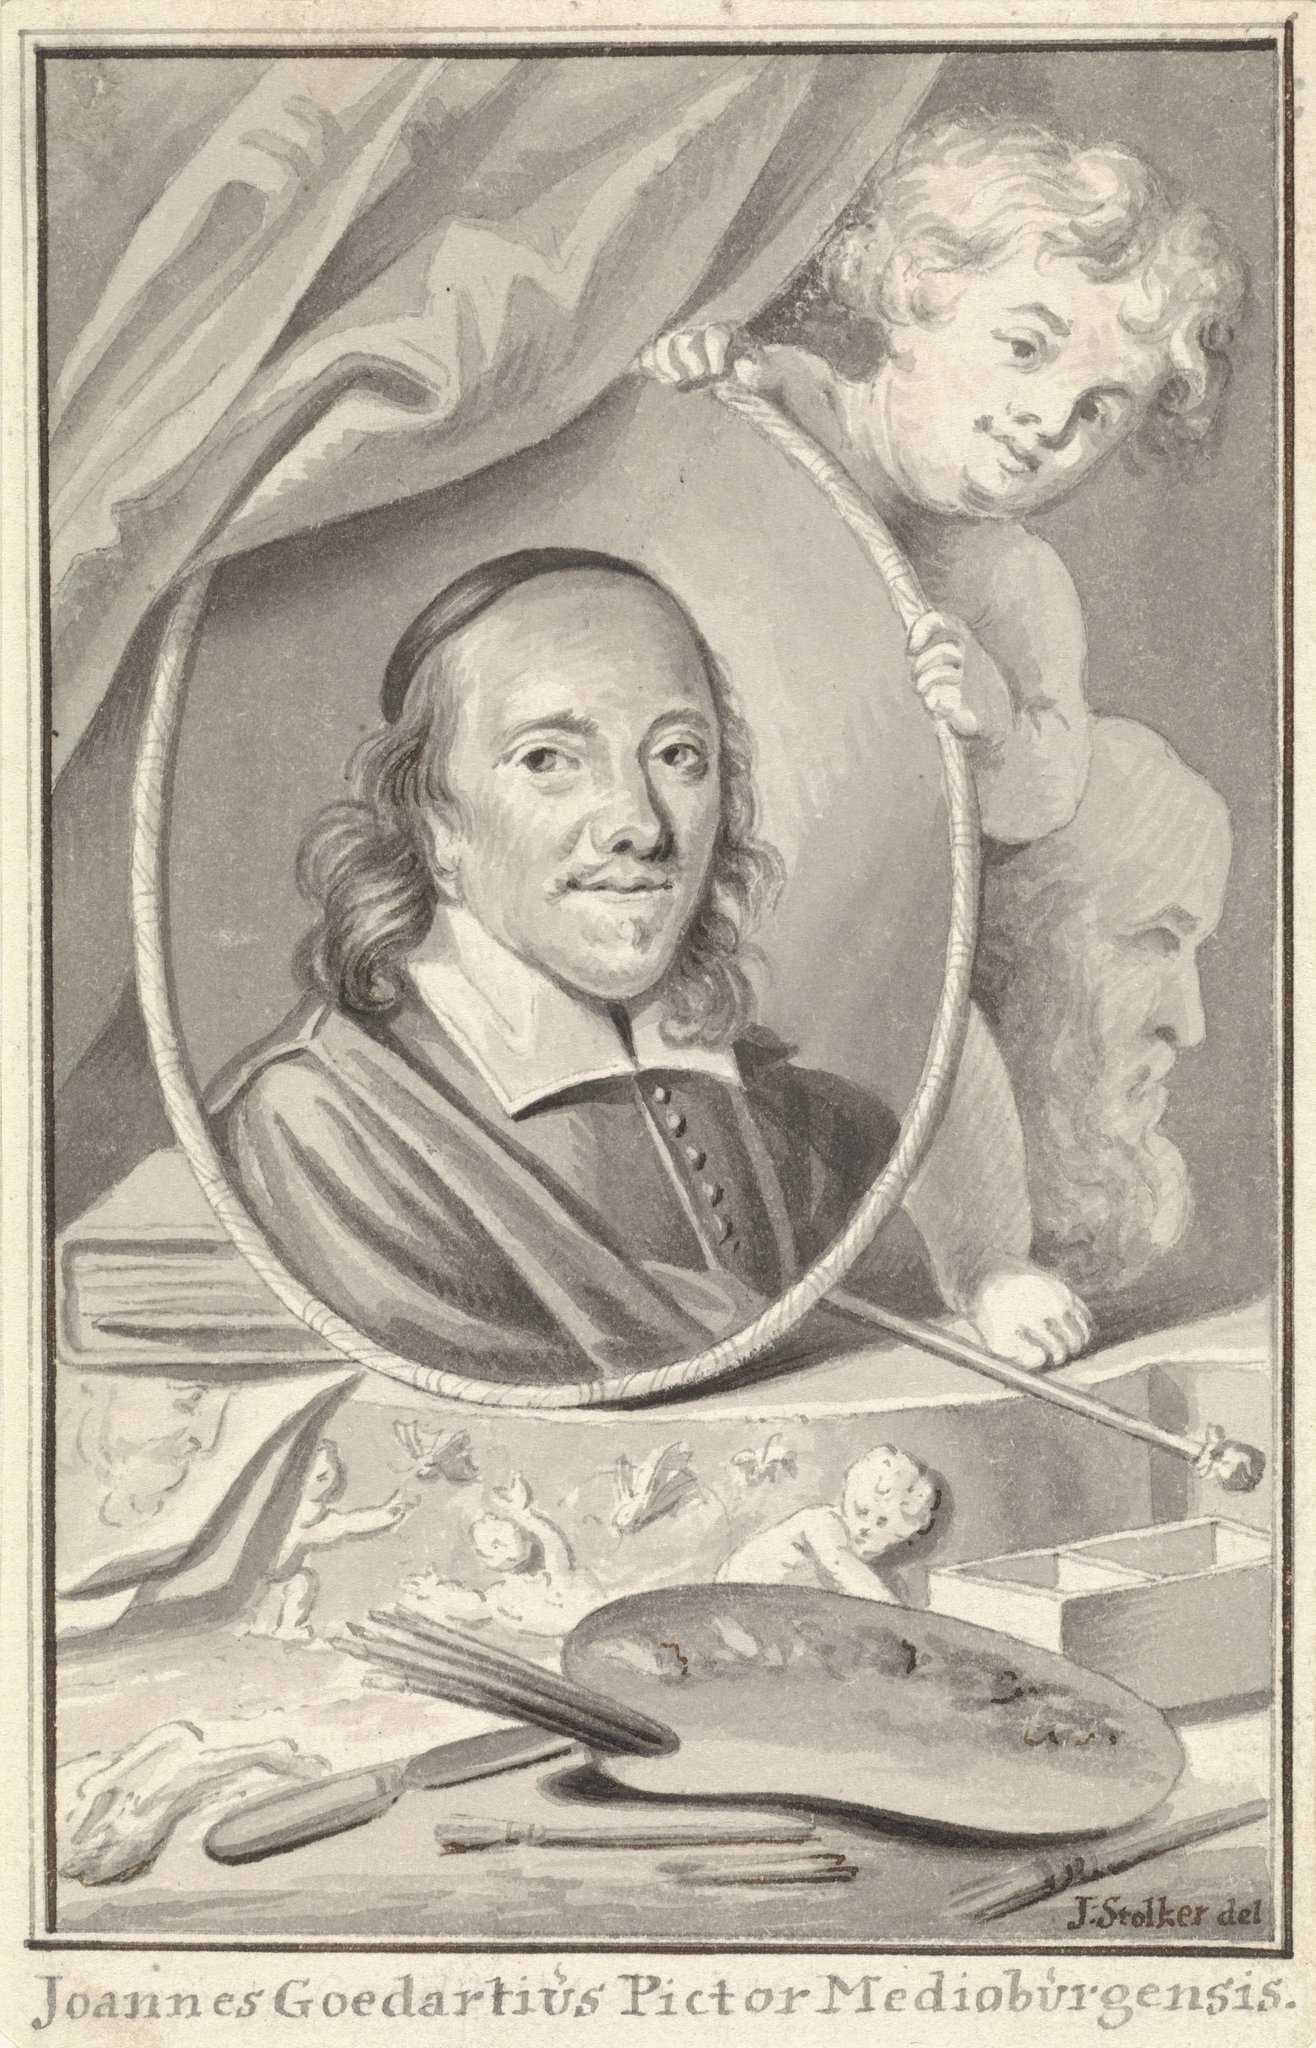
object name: watercolor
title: Portret van Johannes Goedaert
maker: jan stolker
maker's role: draughtsman, painter, print maker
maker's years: 1724-1785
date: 1734-1785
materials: paper, watercolor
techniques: brush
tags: middelburg, print maker, draughtsman, johannes goedaert, historical persons, portrait, self-portrait of painter, portrait, self-portrait of artist, portrait, self-portrait of draughtsman